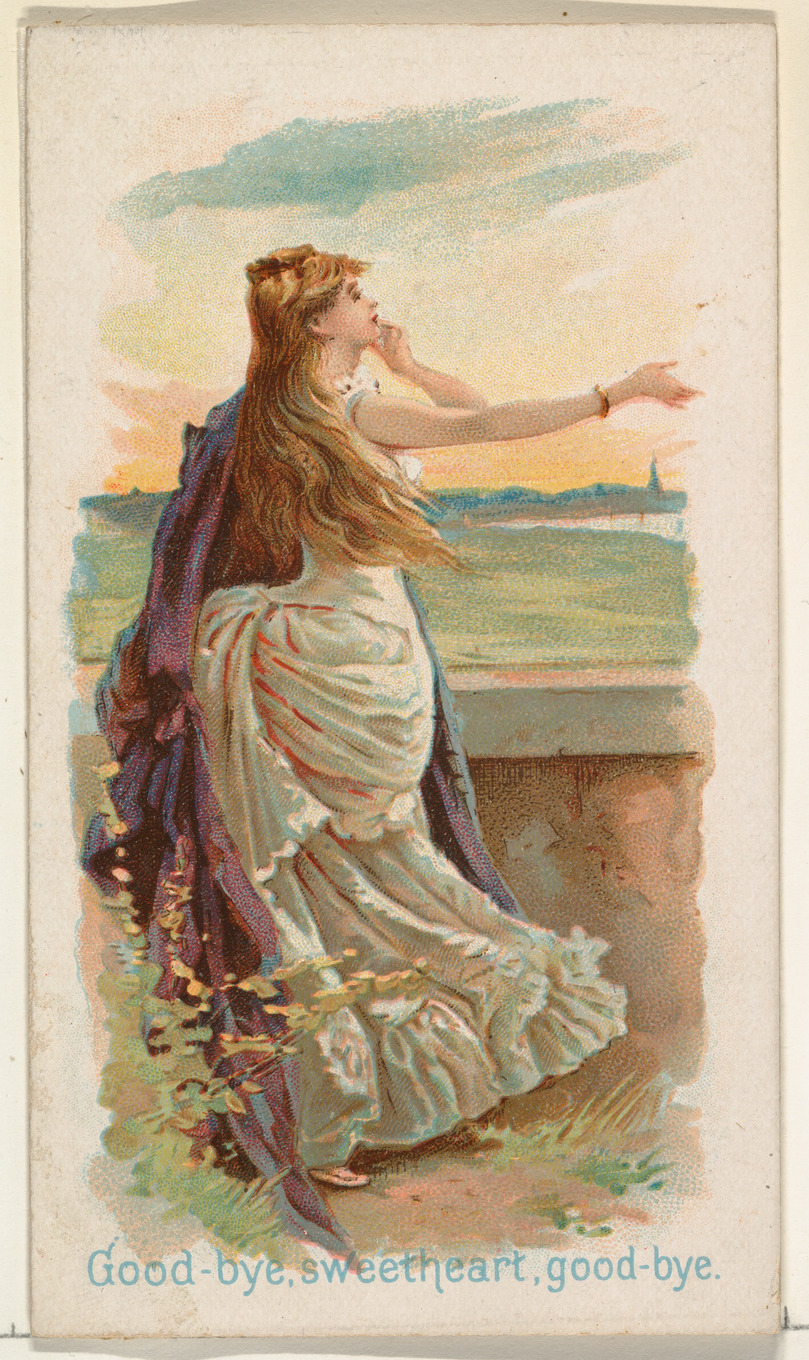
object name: print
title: Good Bye, Sweetheart, Good Bye, from the Illustrated Songs series (N116) issued by W. Duke, Sons & Co. to promote Honest Long Cut Tobacco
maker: w. duke, sons & co.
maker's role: publisher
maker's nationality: american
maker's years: 1870-1920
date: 1893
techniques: color lithograph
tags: profiles,women